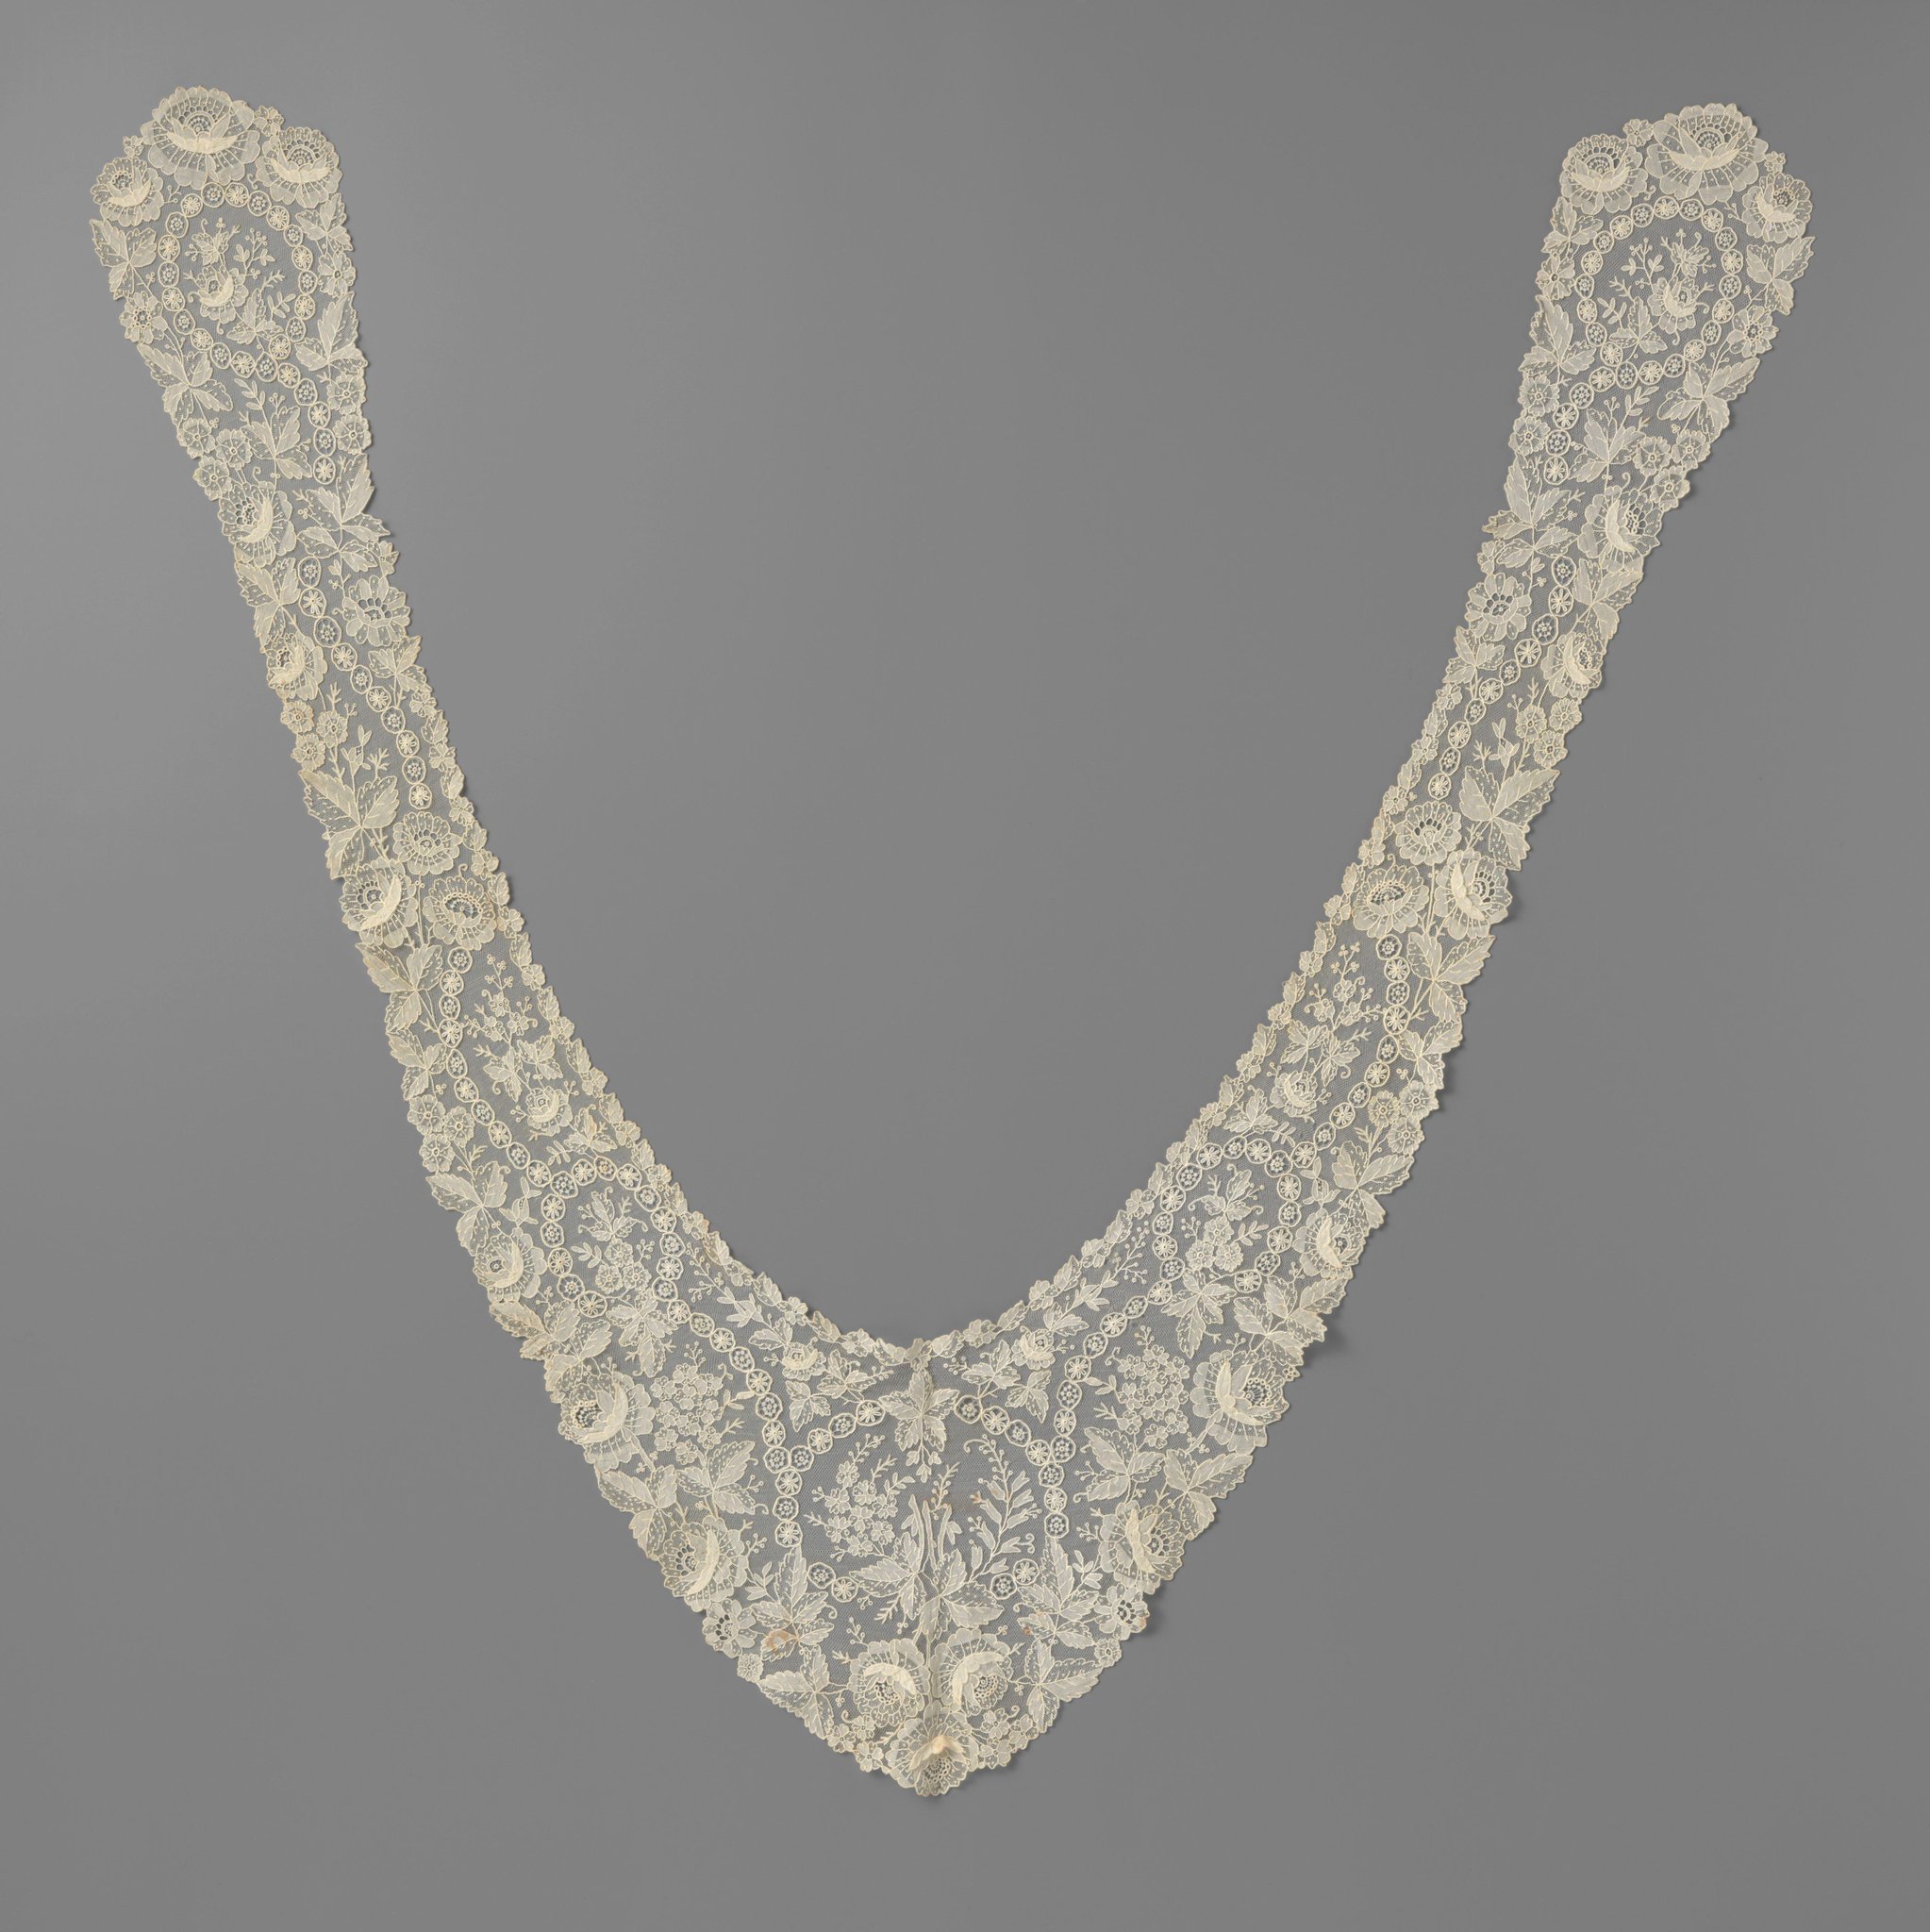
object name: collar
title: Shawlkraag van naaldkant met schakelketting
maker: Anonymous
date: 1870-1880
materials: linen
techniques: needle lace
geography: brussels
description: Een puntig verbreed rugstuk verbindt twee lange, smalle slippen met verbrede uiteinden. Een slingerband van aaneengeschakelde wieltjes is vijfmaal in een lus gelegd, waarbinnen telkens een rozentakje. De roosjes vertonen opgelegd reliëf van halvemaanvormige bloemblaadjes. Het boeket in het rugstuk bestaat uit drie hangende rozentakjes. De drie- of vijftallige blaadjes worden alle door de middennerf gedeeld in een dicht gesloten helft en een open helft met spikkels. Point de gaze de Bruxelles.